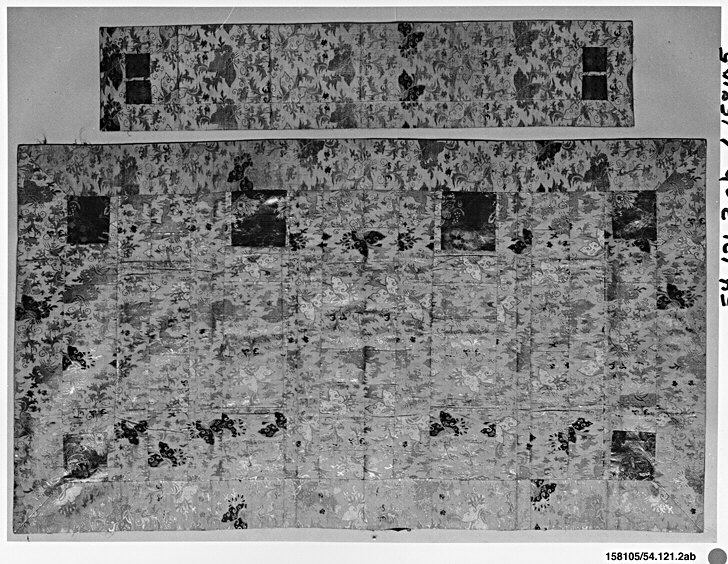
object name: robe, priest's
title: Priest's Robe and Stole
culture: japanese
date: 1767-1800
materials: metal thread, silk